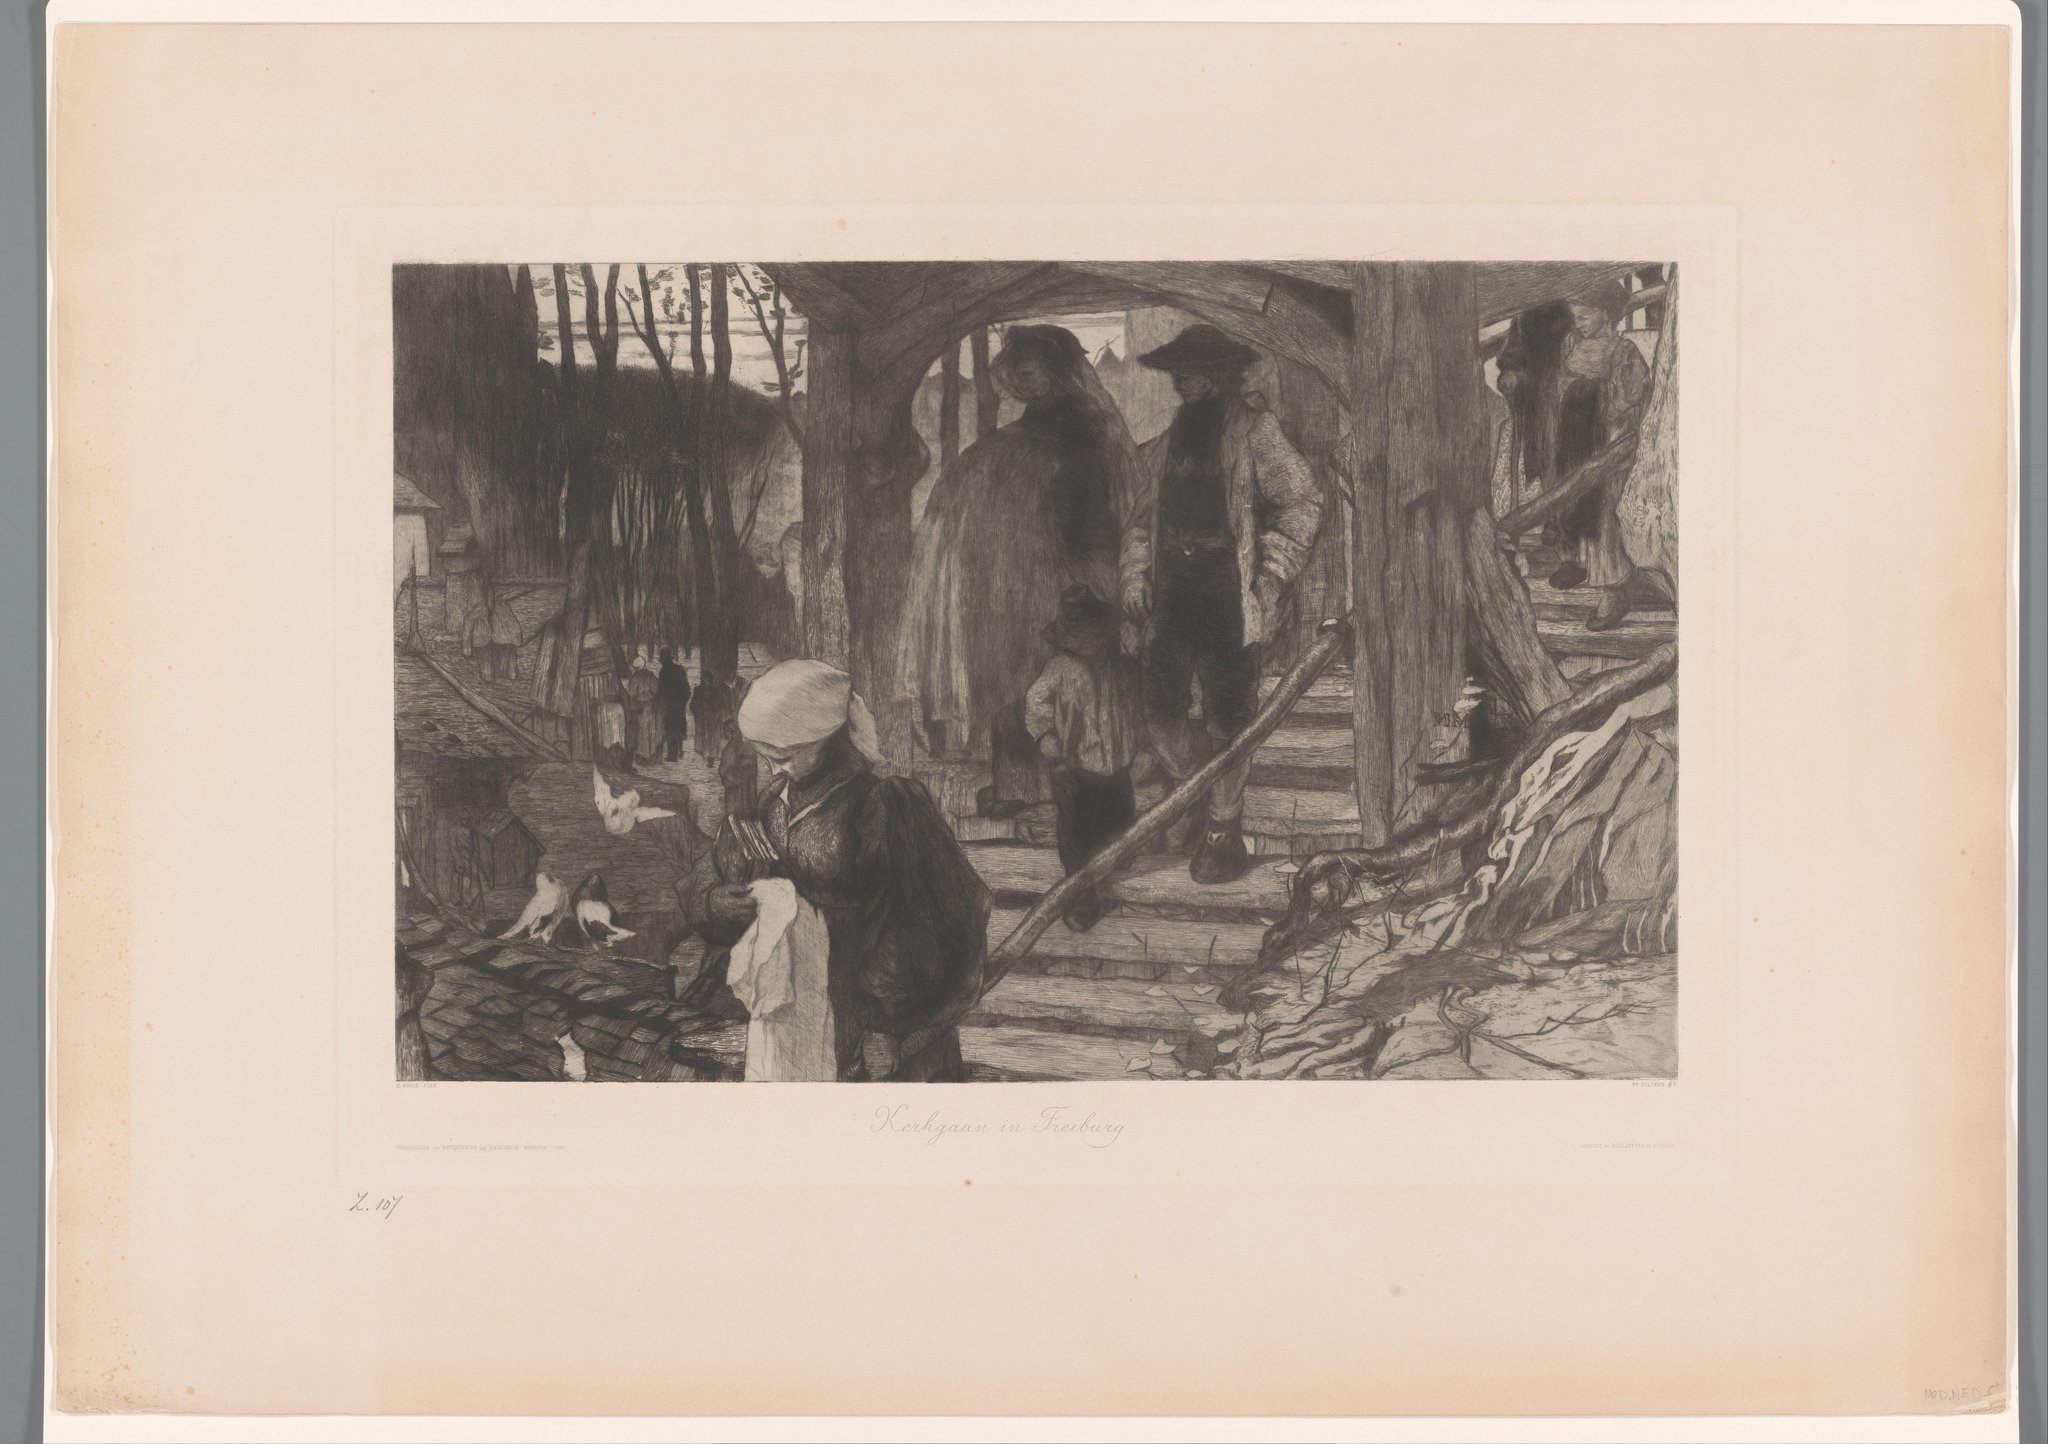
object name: print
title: Kerkgaan in Freiburg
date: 1888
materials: paper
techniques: etching, intaglio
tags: going to church, family group, especially parents with their child(ren)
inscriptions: collector's mark: Lugt 2228